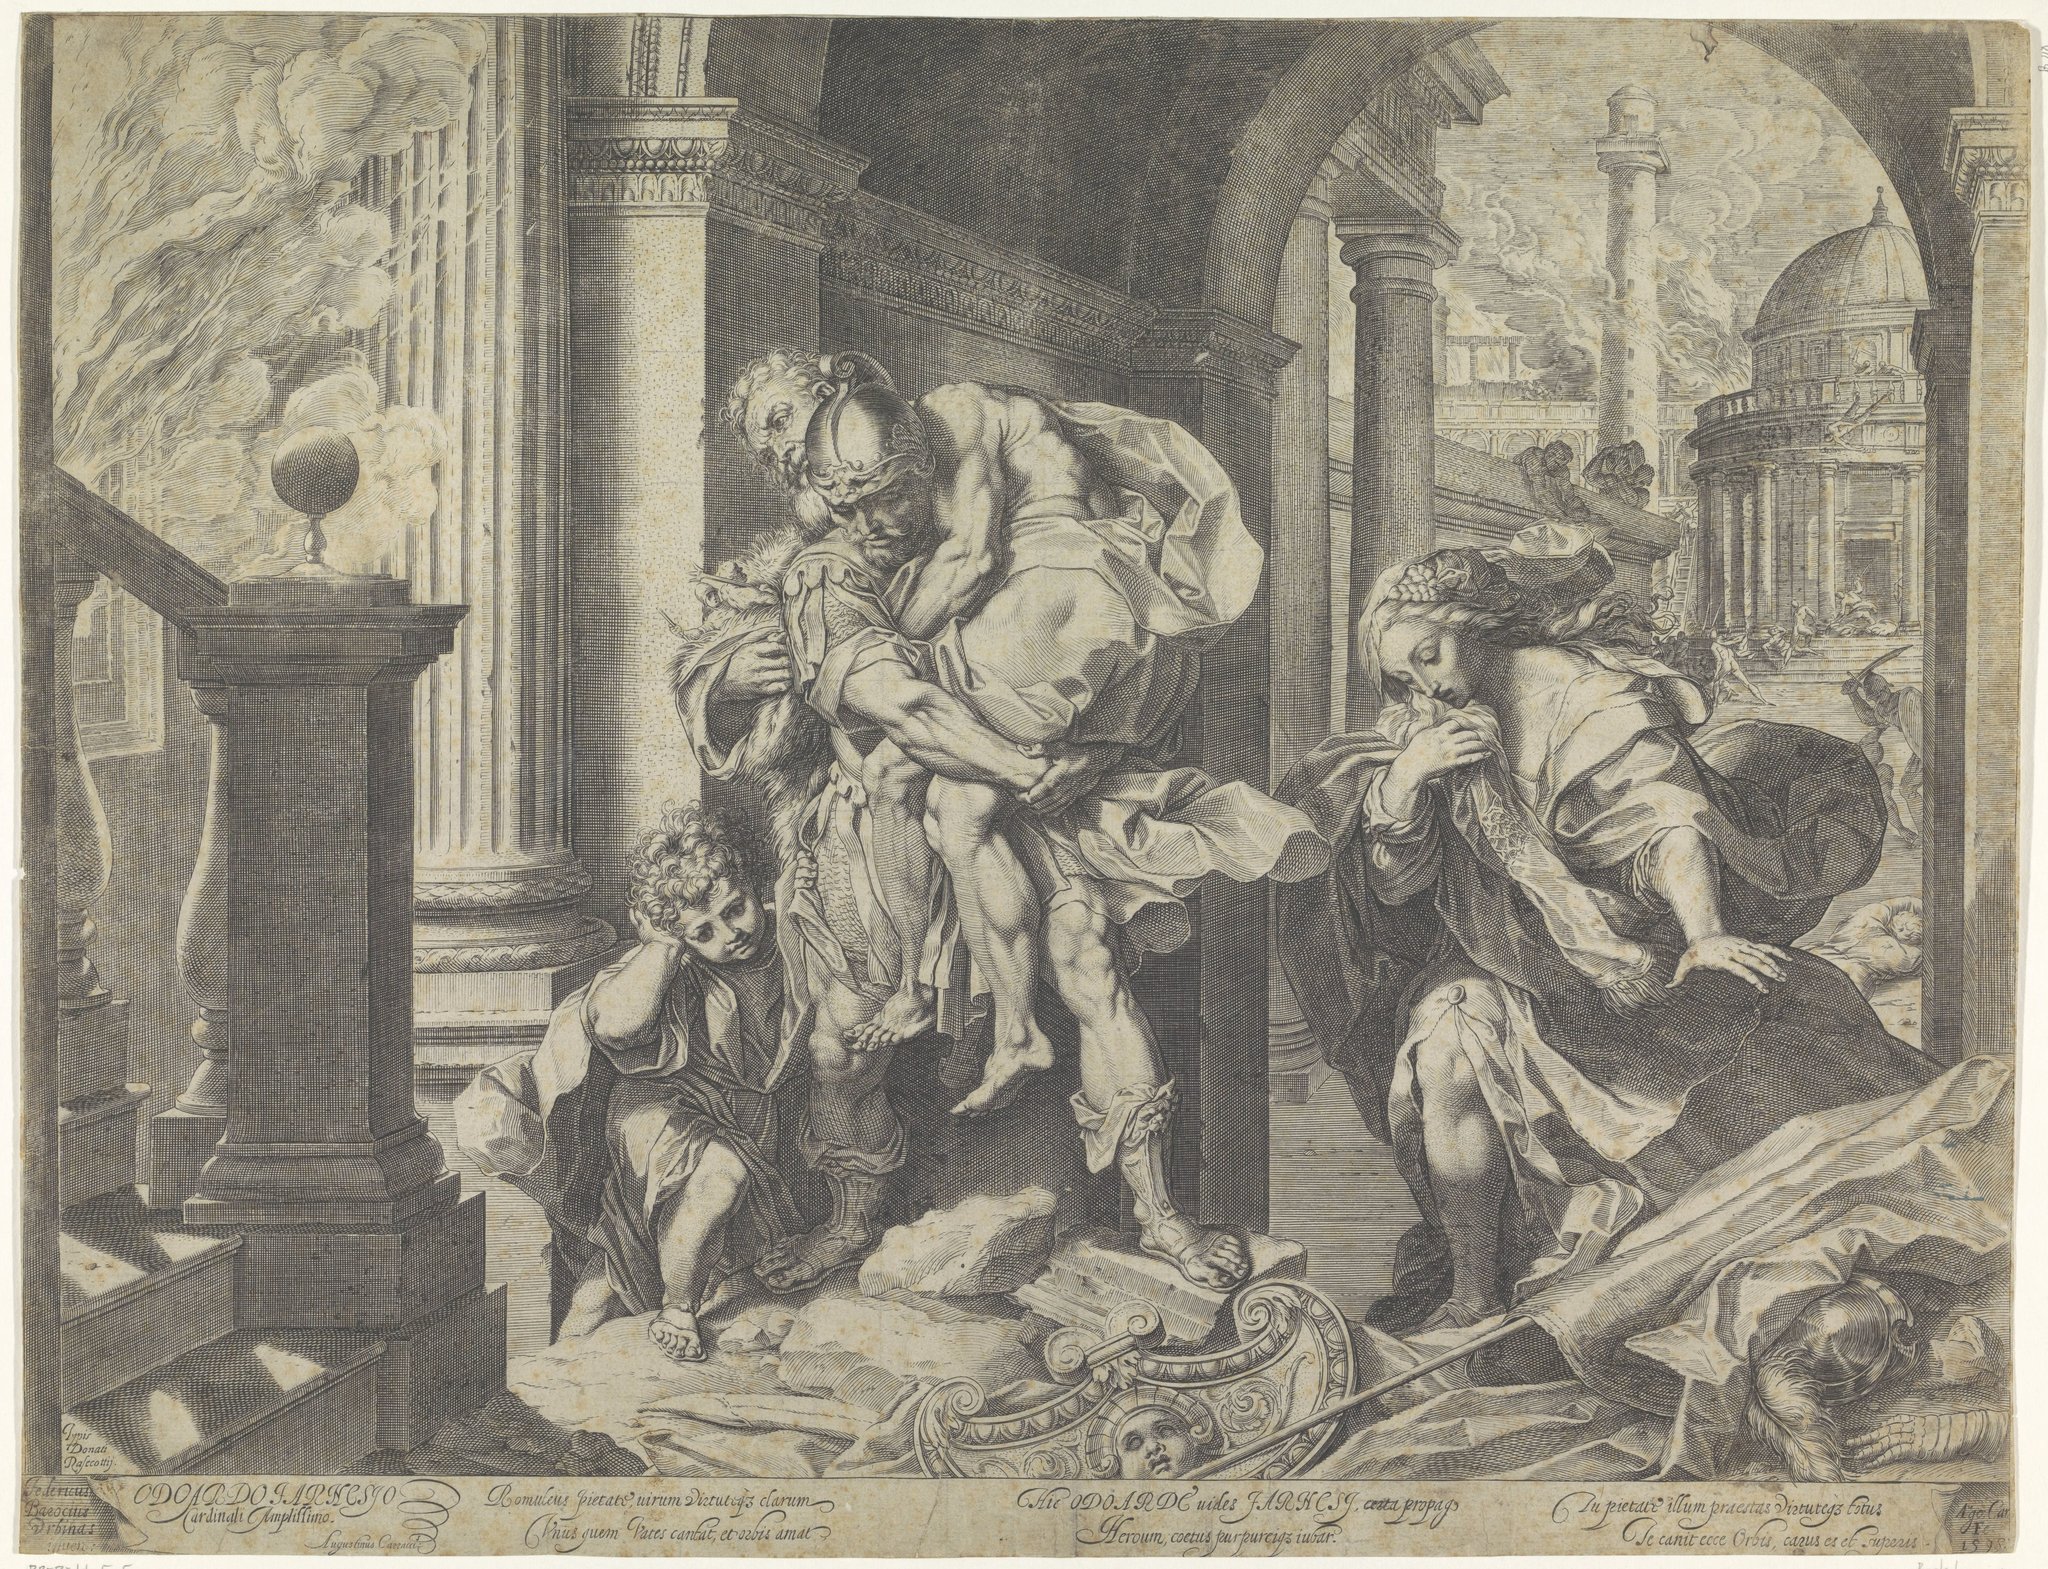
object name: print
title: Aeneas vlucht met zijn familie uit Troje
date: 1595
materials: paper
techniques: engraving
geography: italy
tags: 'pius aeneas': aeneas, leading ascanius, escapes from burning troy, carrying his father anchises with the penates; his wife creusa, who sets out with them, is lost on the way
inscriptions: collector's mark: ‘Hinloopen’, collector's mark: Lugt 10, collector's mark: Lugt 11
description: Naar een karton voor een schilderij in het Musée du Louvre te Parijs of naar een verloren gegaan schilderij voor het hof van Rudolf II te Praag door Federico Barocci. Een tweede versie van het schilderij door Barocci is wel over en hangt in de Galleria Borghese te Rome. Er is ook een studie in olieverf bewaard gebleven door Agostino Carracci in Windsor Castle te Windsor.